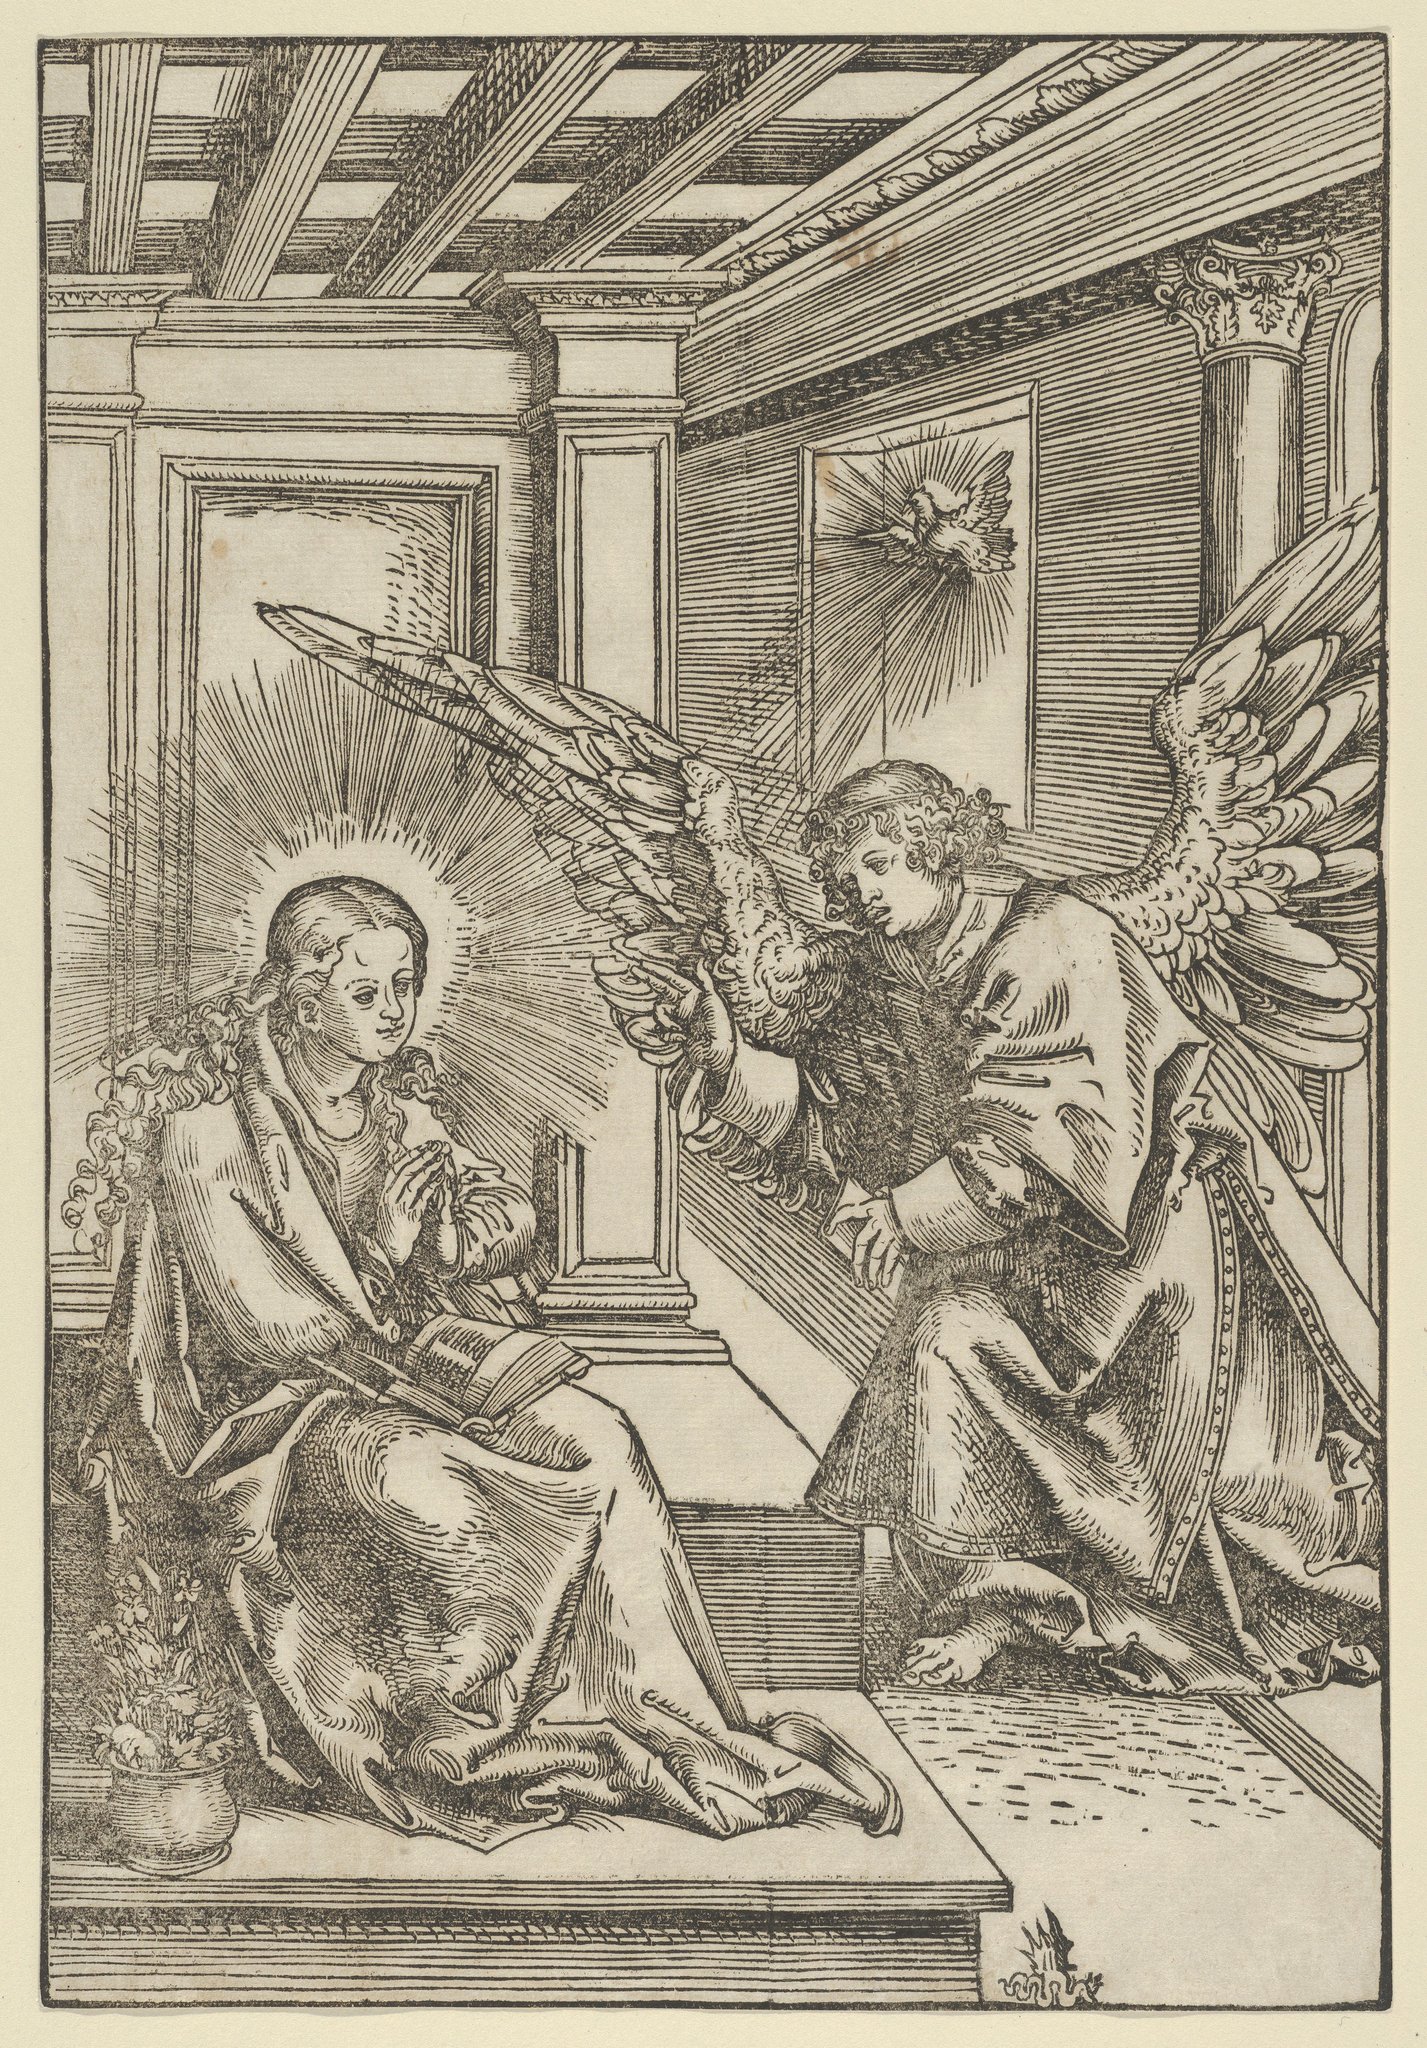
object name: print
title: The Annunciation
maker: lucas cranach the elder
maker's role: artist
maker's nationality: german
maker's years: 1472-1553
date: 1472-1553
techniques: woodcut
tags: angels,virgin mary,annunciation